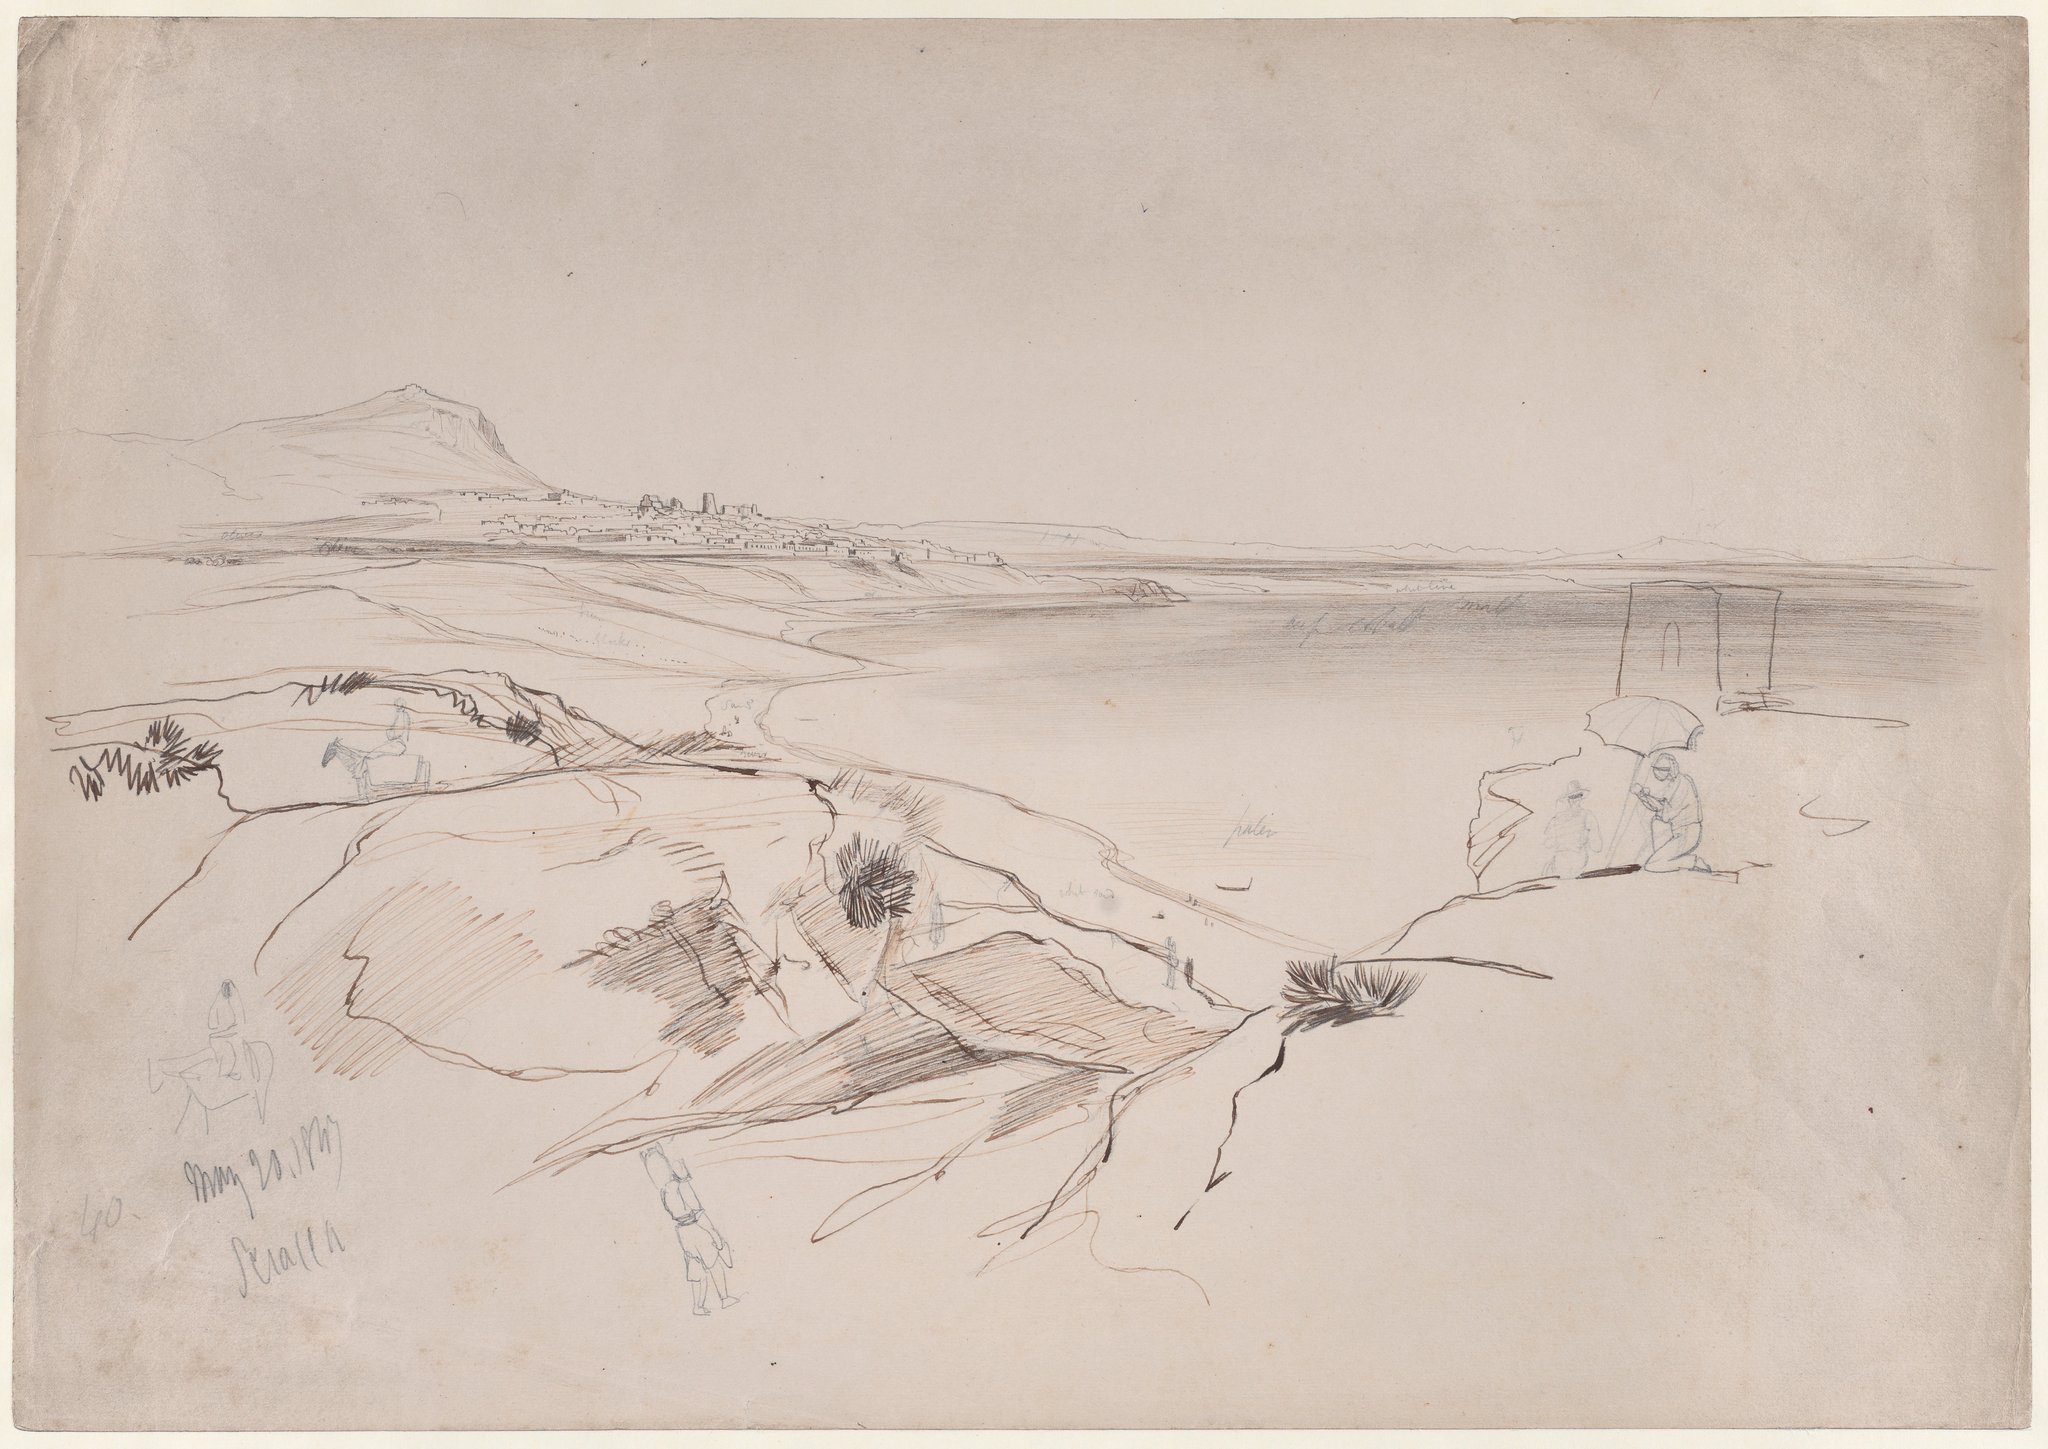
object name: drawing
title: View of Sciacca, Sicily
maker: edward lear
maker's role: artist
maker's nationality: british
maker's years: 1812-1888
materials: graphite, ink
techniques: pen